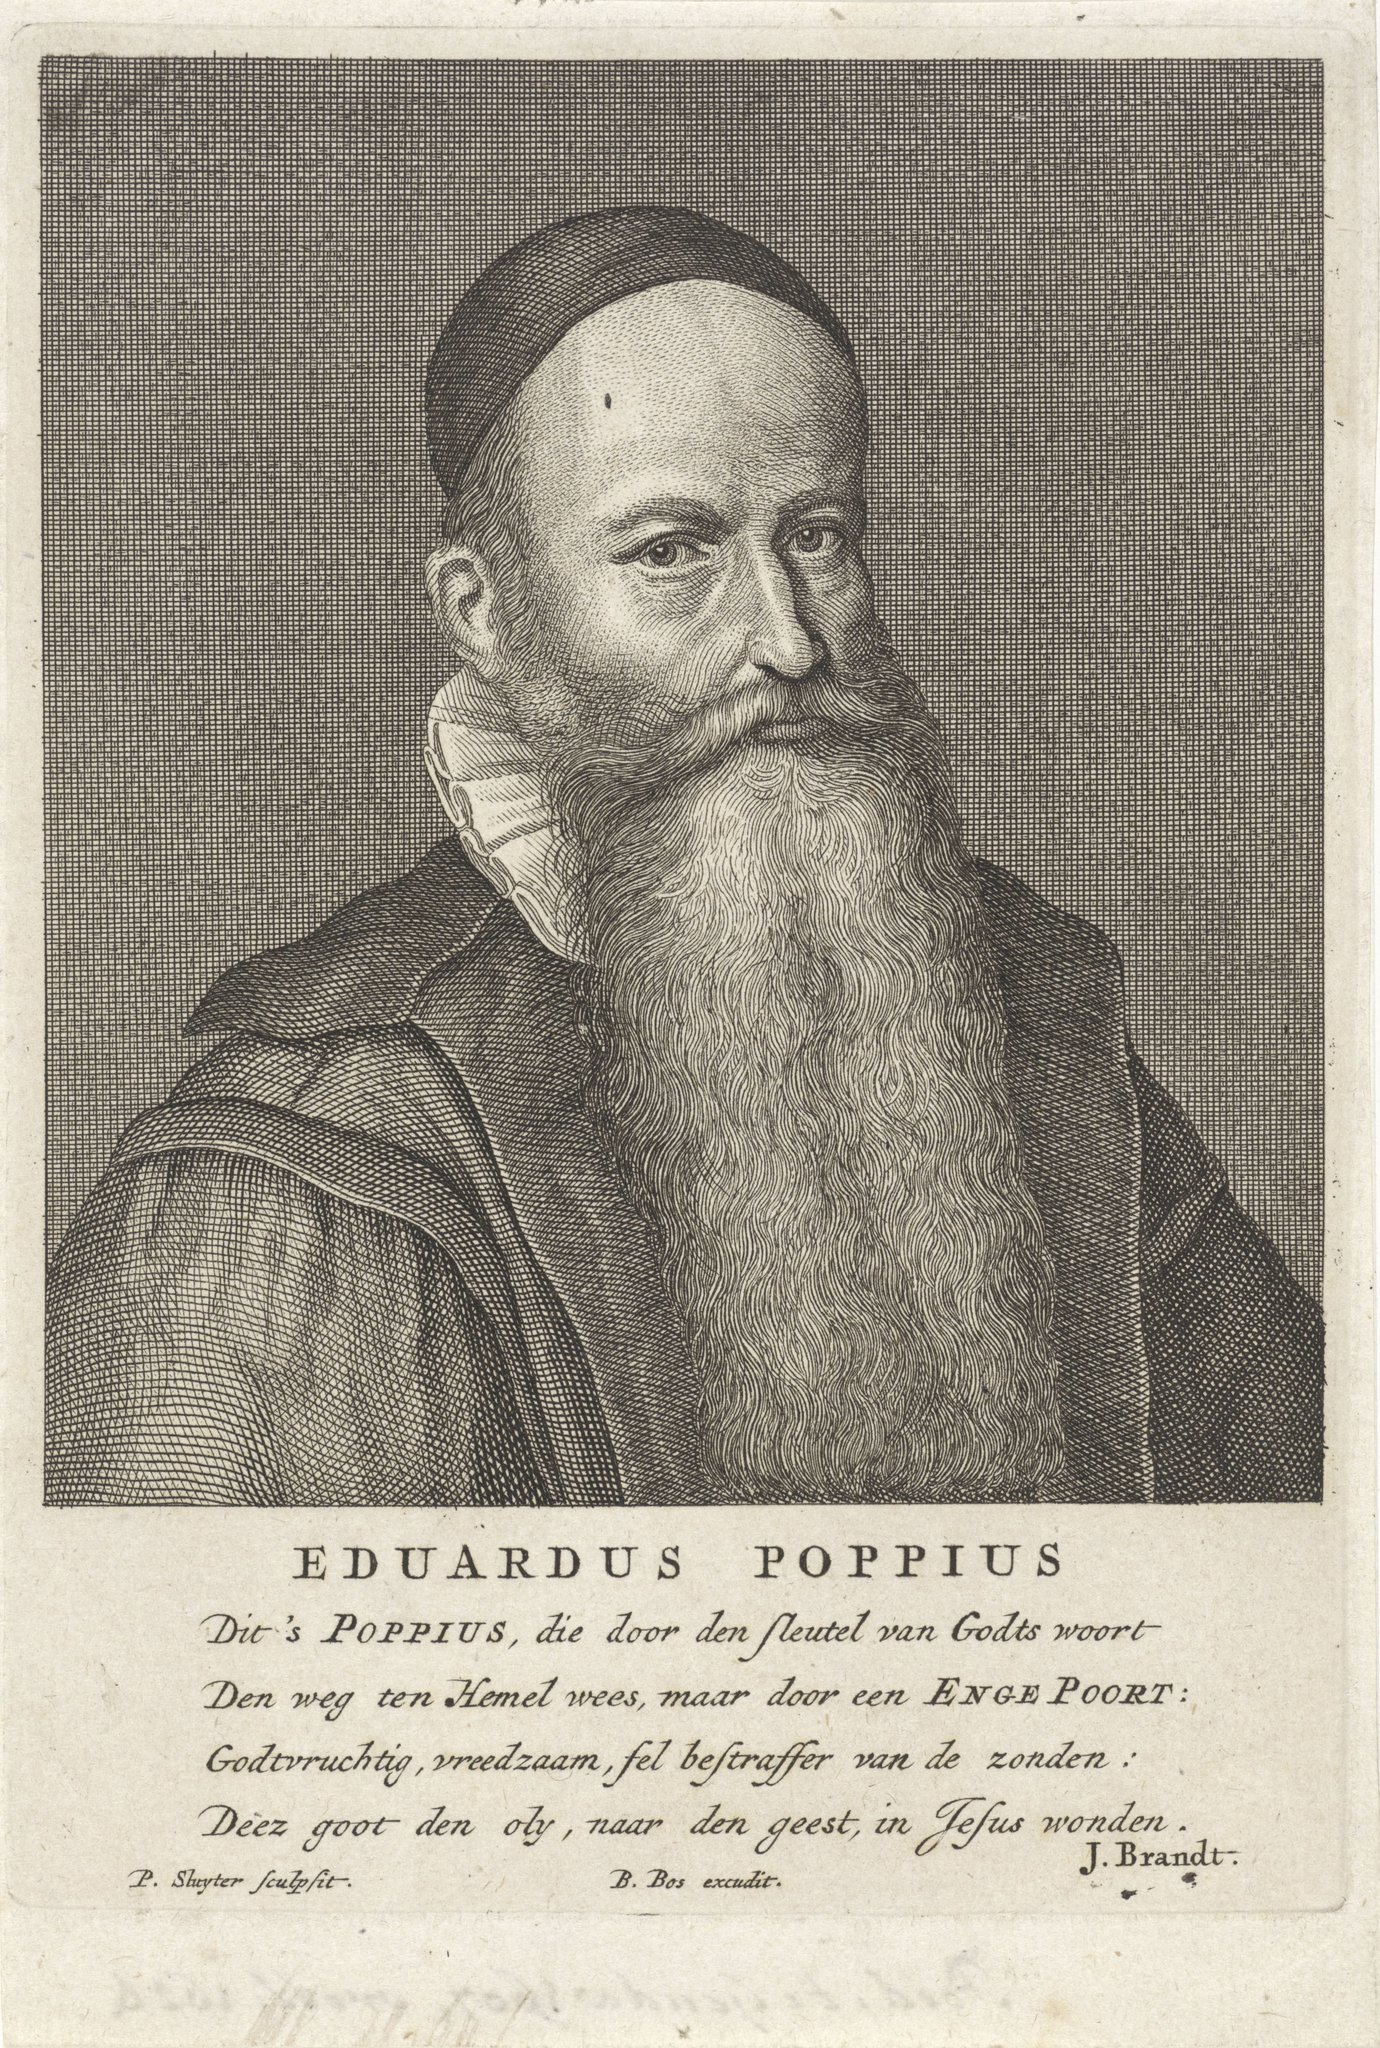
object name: print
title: Portret van Eduard Poppius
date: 1704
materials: paper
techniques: engraving, etching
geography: rotterdam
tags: historical persons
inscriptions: inscription: ‘Pred. te Gouda 1607, overl: 1624’, collector's mark: Lugt 2228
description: Prent ook gebruikt in: G. Brandts Historie der Reformatie, en andre kerkelyke geschiedenissen, in en ontrent de Nederlanden. Het vierde deel. Rotterdam: Barent Bos, 1704, tussen p. 1090 en 1091.